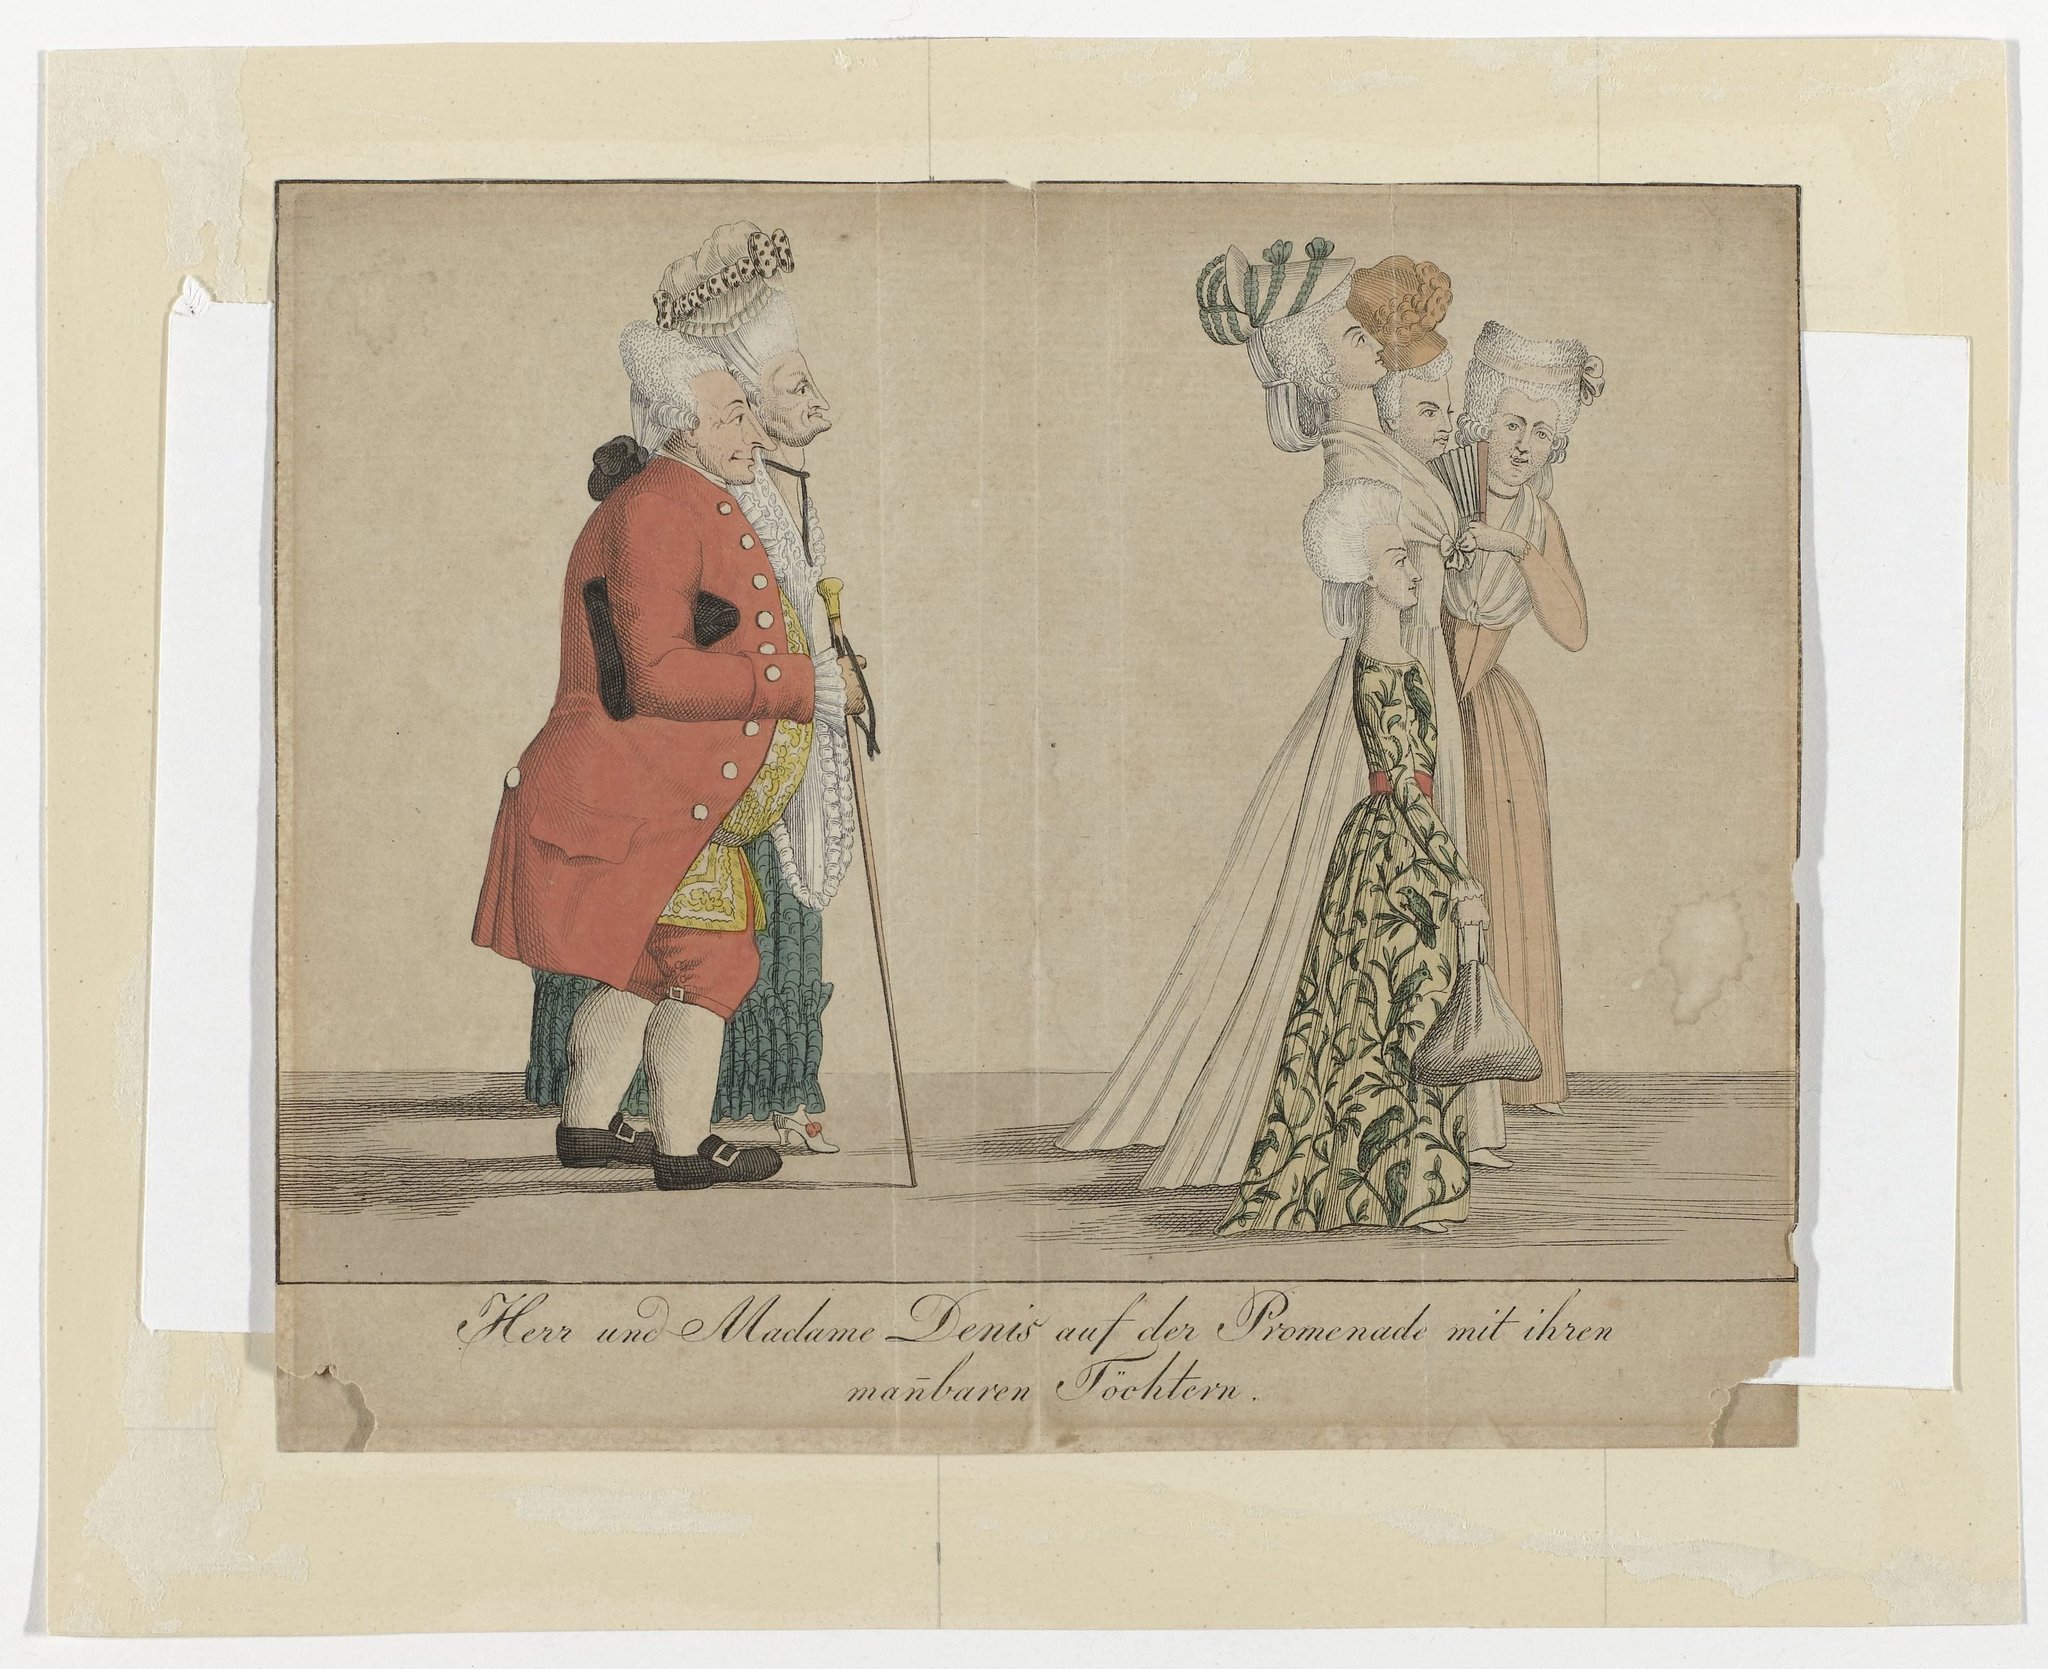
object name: cartoon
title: Herr und Madame Denis, 1785-1786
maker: Anonymous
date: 1785-1786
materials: paper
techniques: engraving, hand coloring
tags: wig - aa - ~ women, caricatures (human types), coat (frac) (+ men's clothes), fashion plates, dress, gown (+ women's clothes), wig, walking-stick, staff, cane (+ men's clothes)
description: Meneer en mevrouw Denis, met hun huwbare dochters flanerend op de promenade.